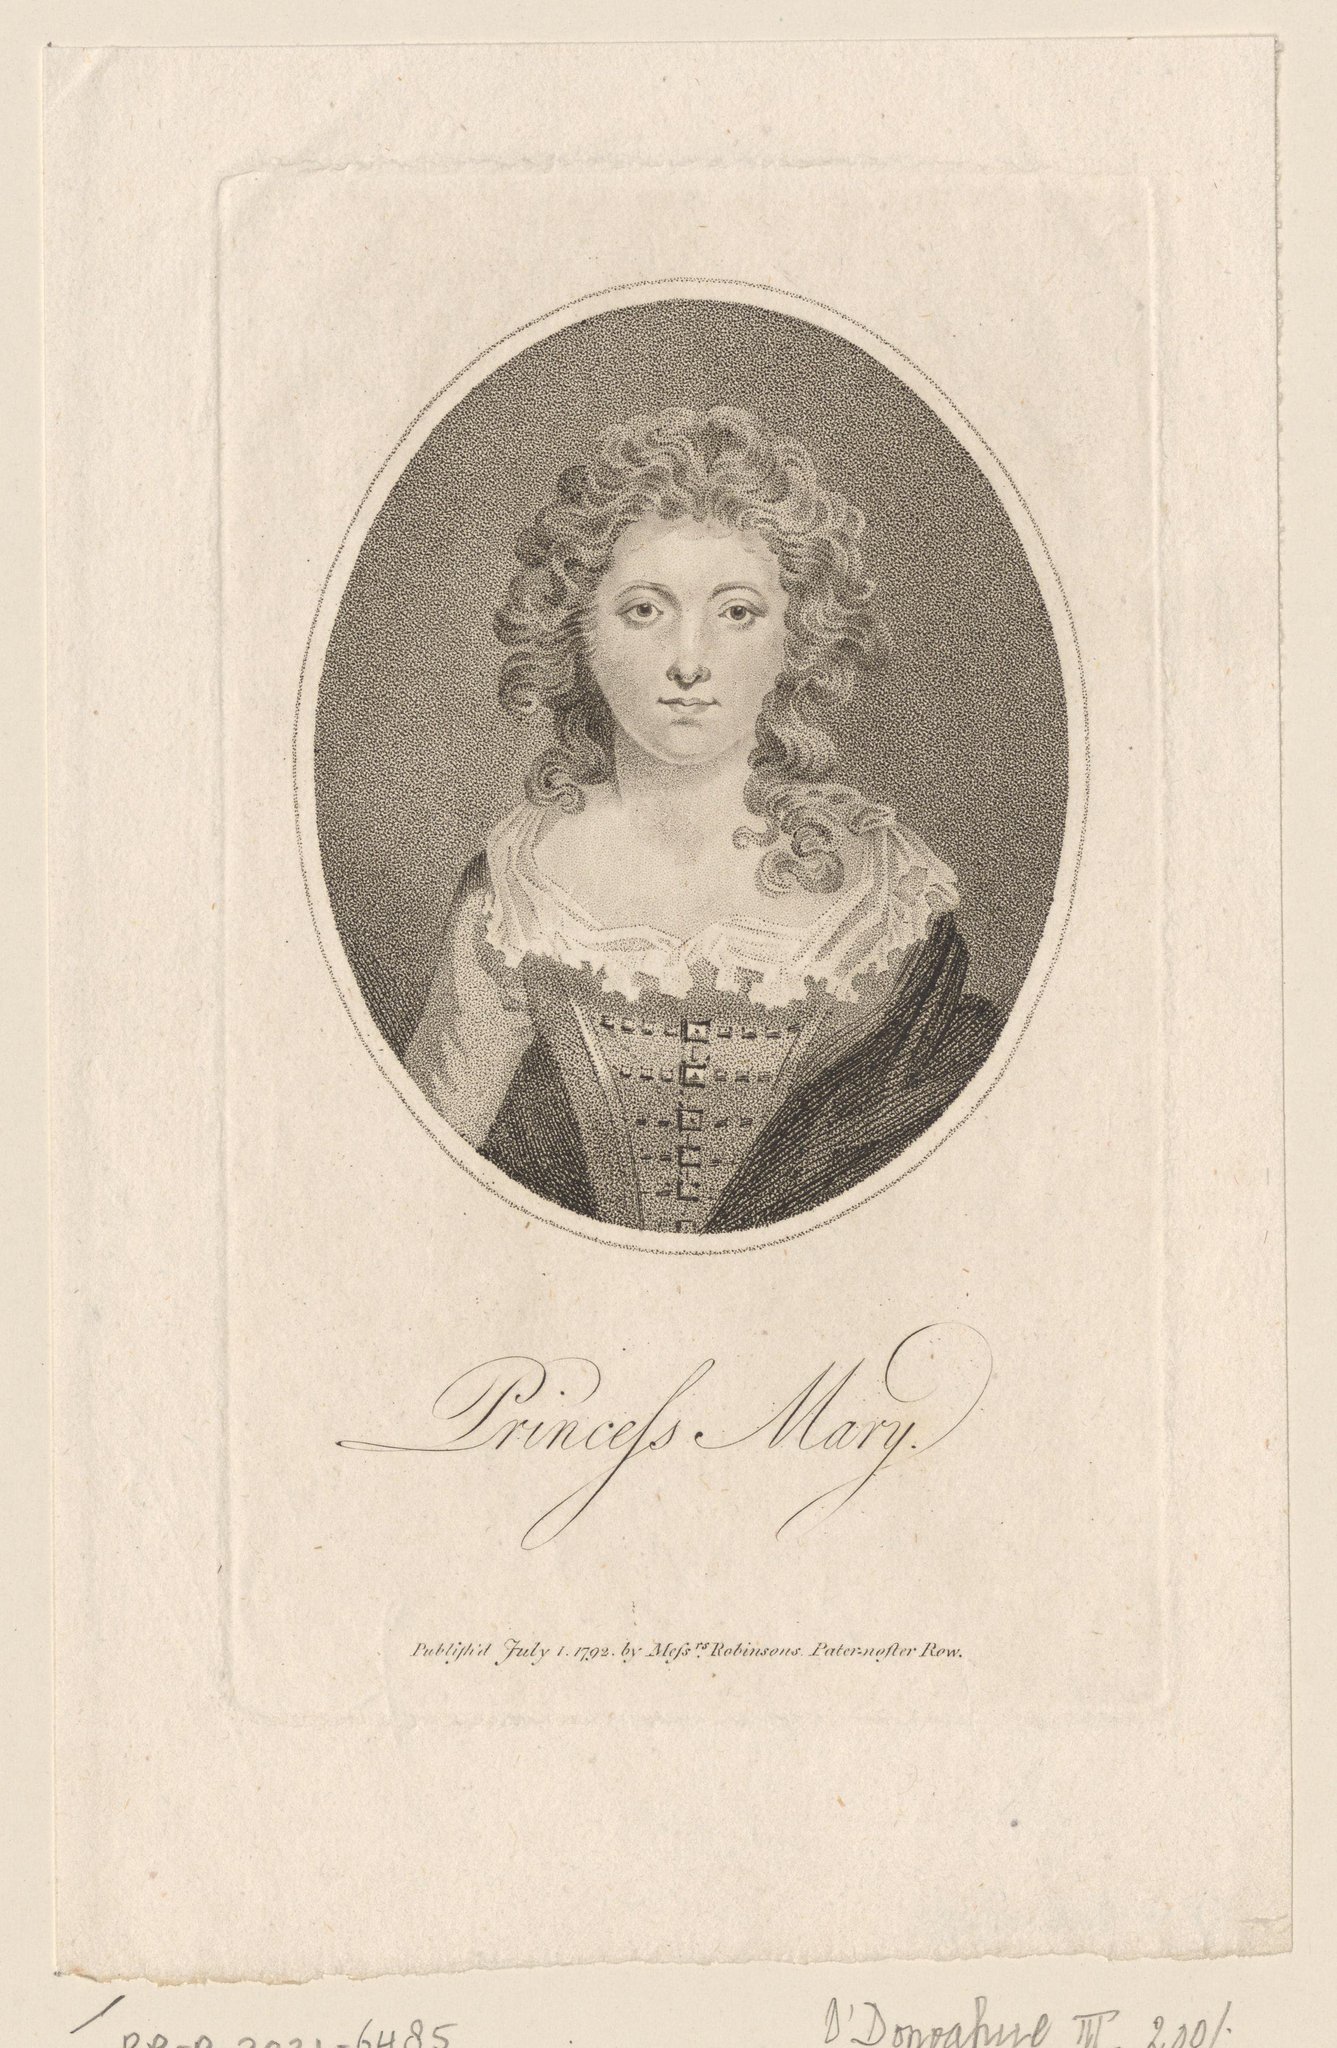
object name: print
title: Portret van Maria van Hannover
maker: Anonymous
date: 1707-1792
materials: paper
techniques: engraving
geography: england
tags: london, historical persons - bb - woman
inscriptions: date